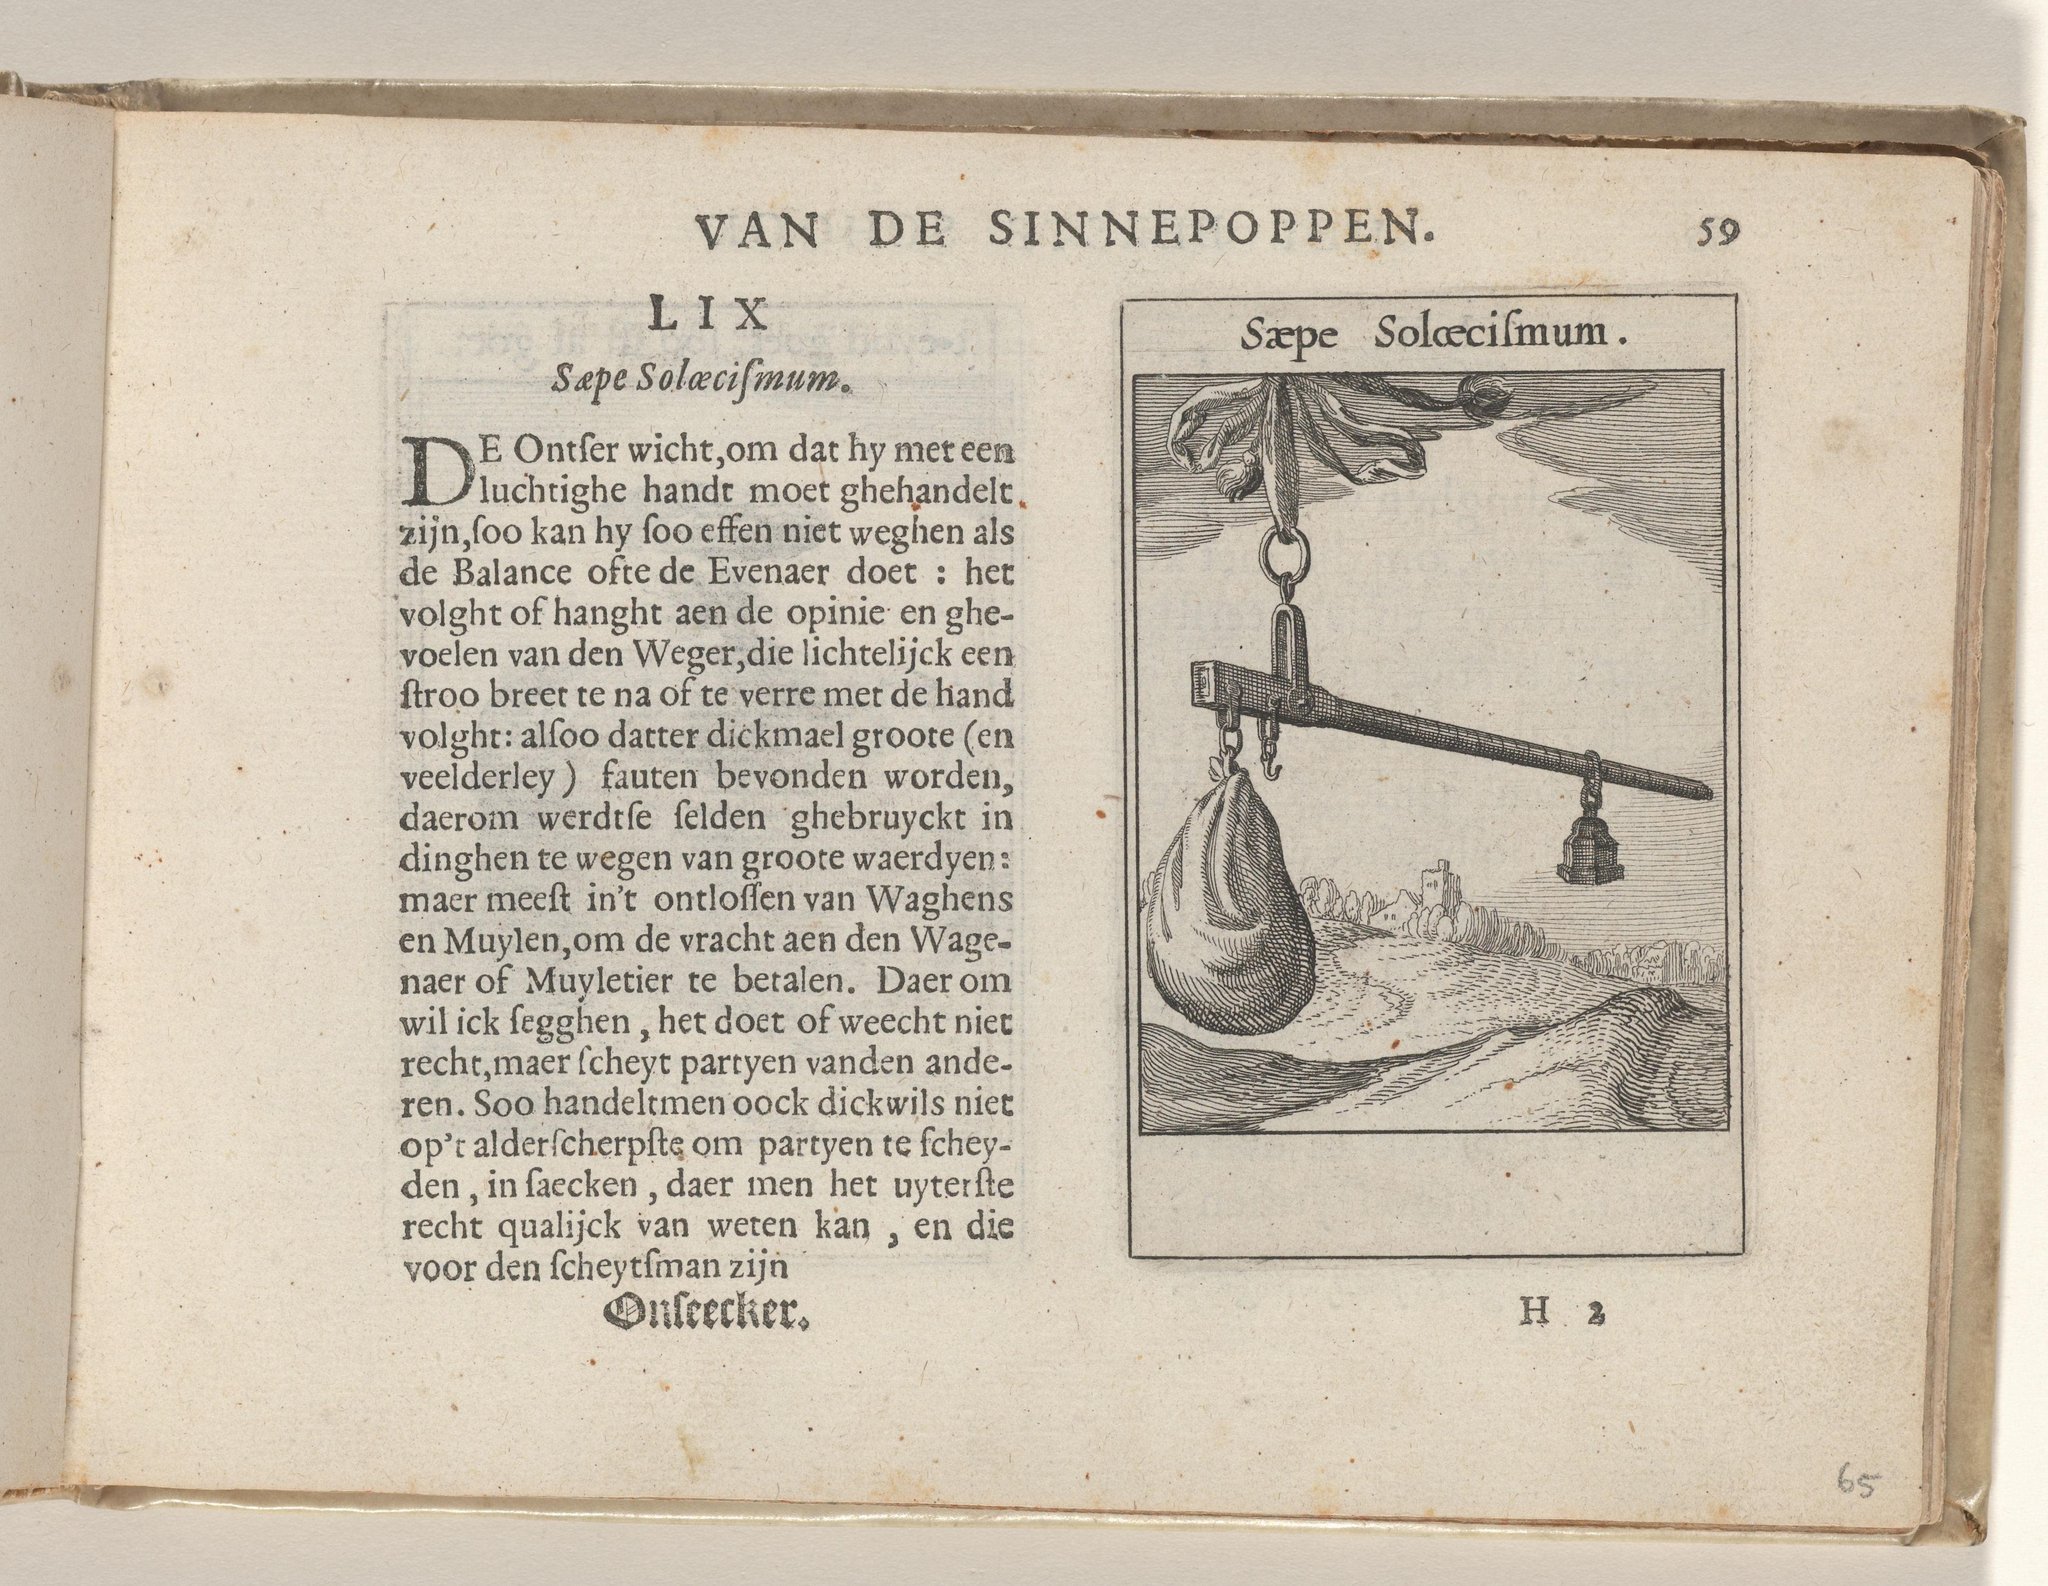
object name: album leaf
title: LIX Saepe Soloecismum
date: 1614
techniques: engraving, printing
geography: amsterdam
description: LIX Saepe Soloecismum. Eerste schok. Onderdeel van 'Sinnepoppen', R. Visscher, 1614.